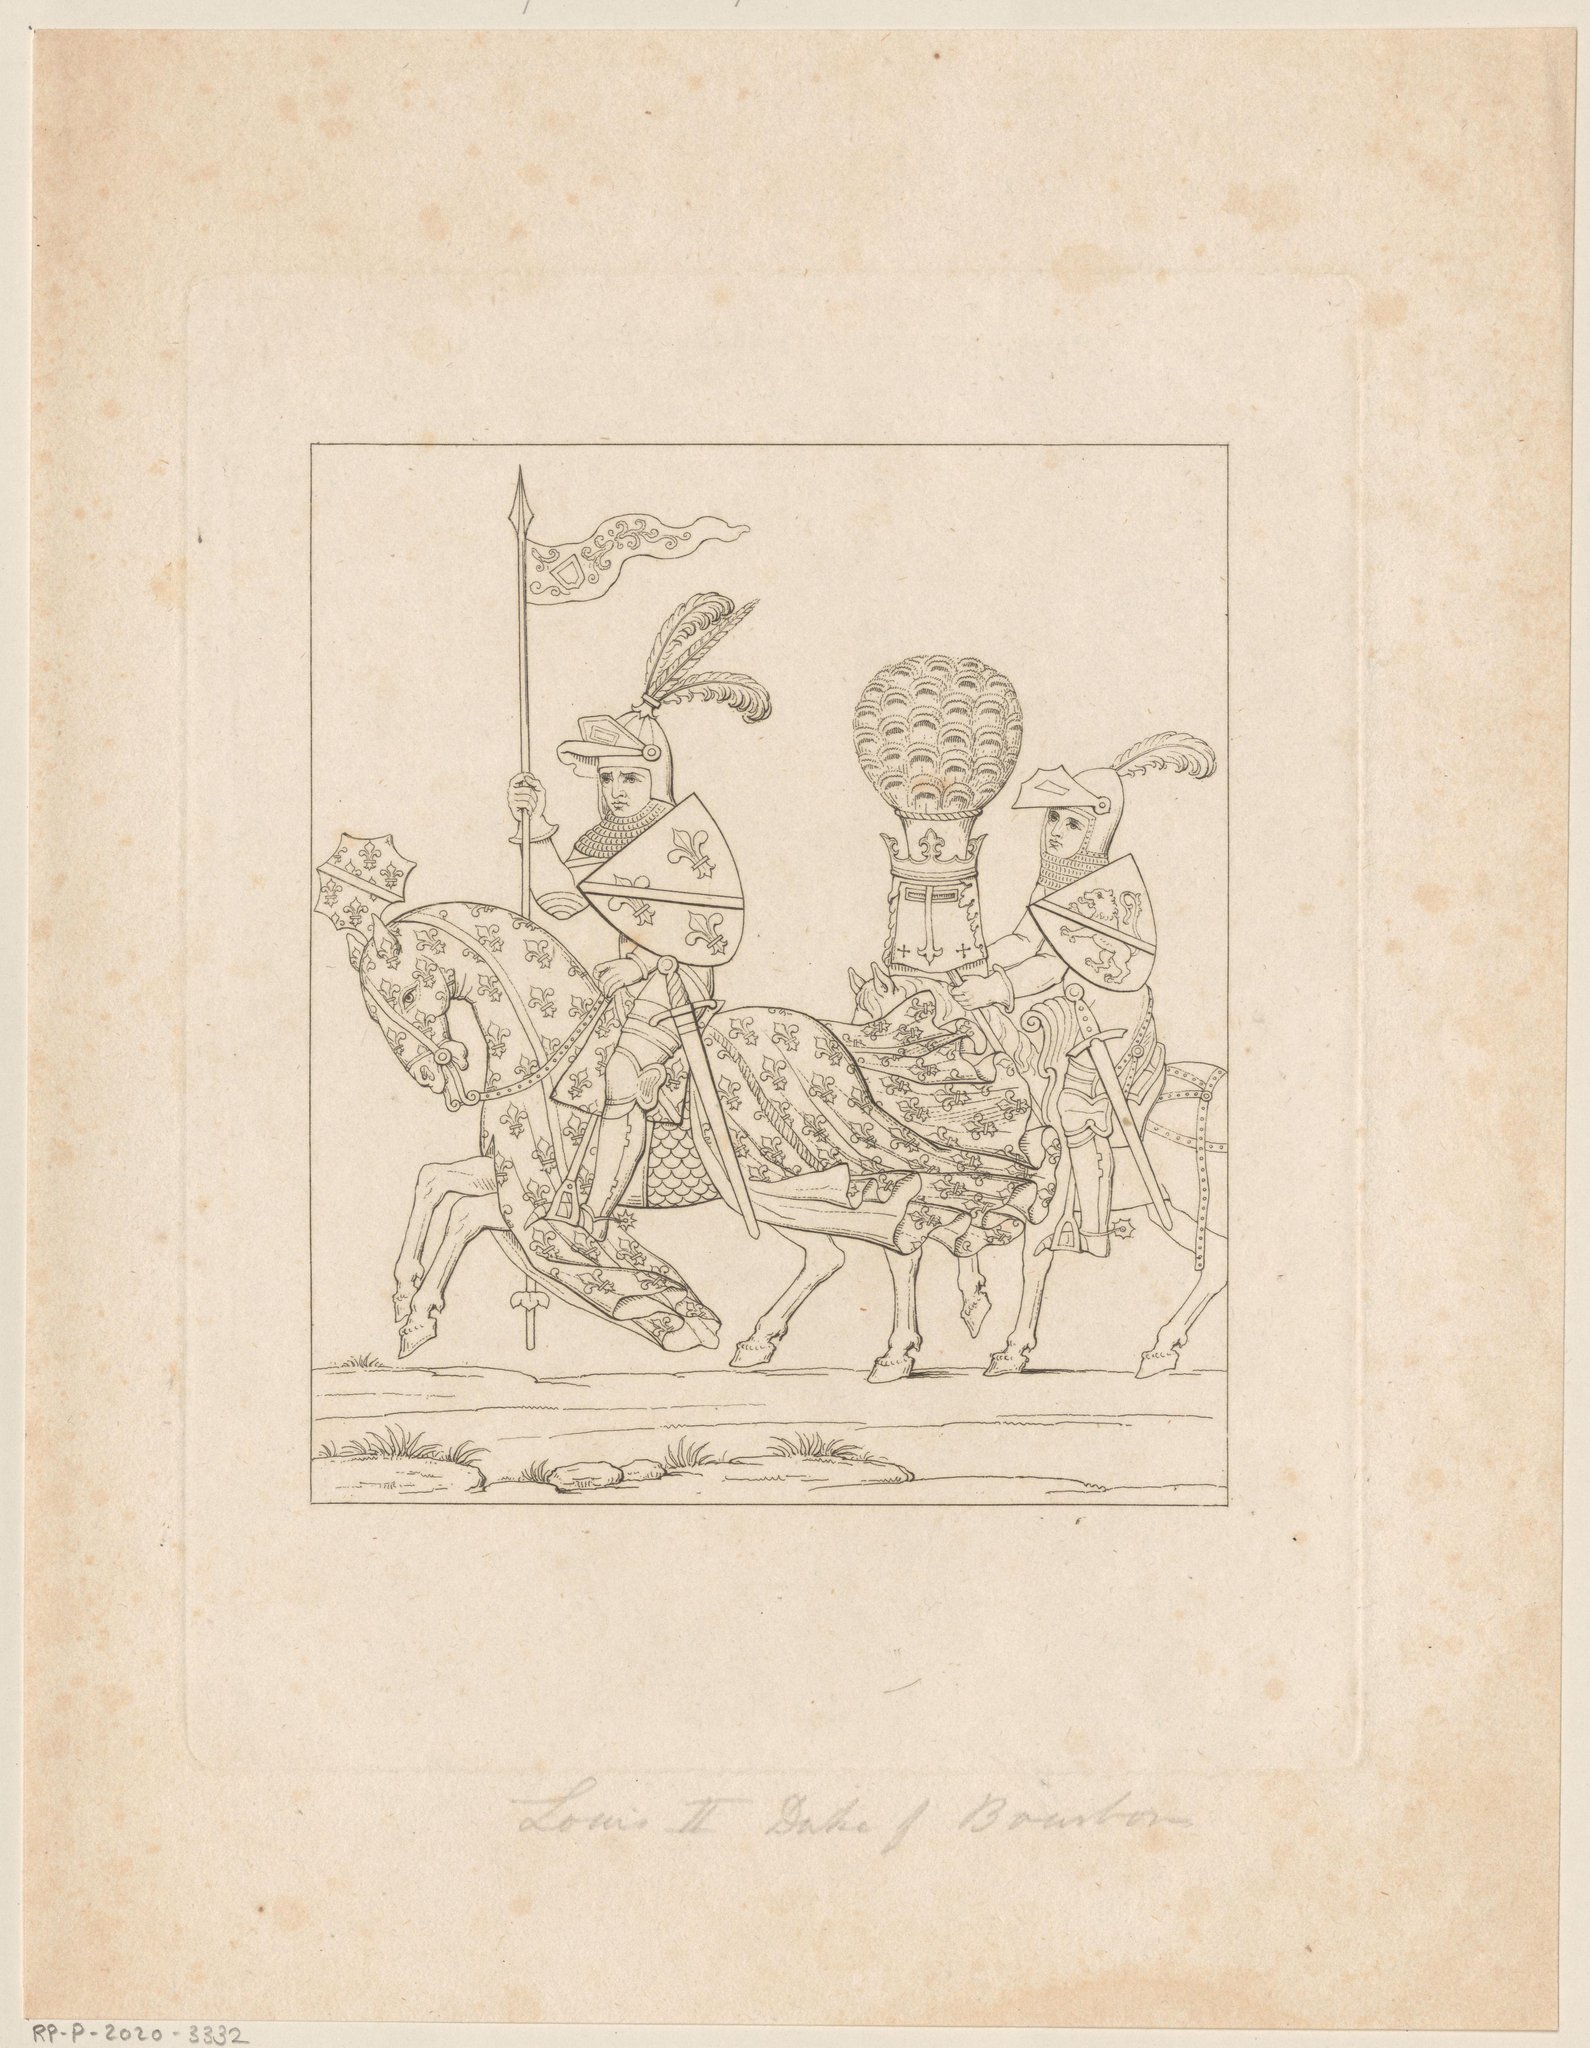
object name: print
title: Ruiterportret van Lodewijk II, hertog van Bourbon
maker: Anonymous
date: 1750-1799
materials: paper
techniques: etching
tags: equestrian state-portrait, armour, historical persons, armorial bearing, heraldry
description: Prent naar illustratie uit: Montfaucon, Bernard de. Les monumens de la Monarchie Françoise (...). Parijs: Julien-Michel Gandouin en Pierre-François Giffart, 1729-1733.